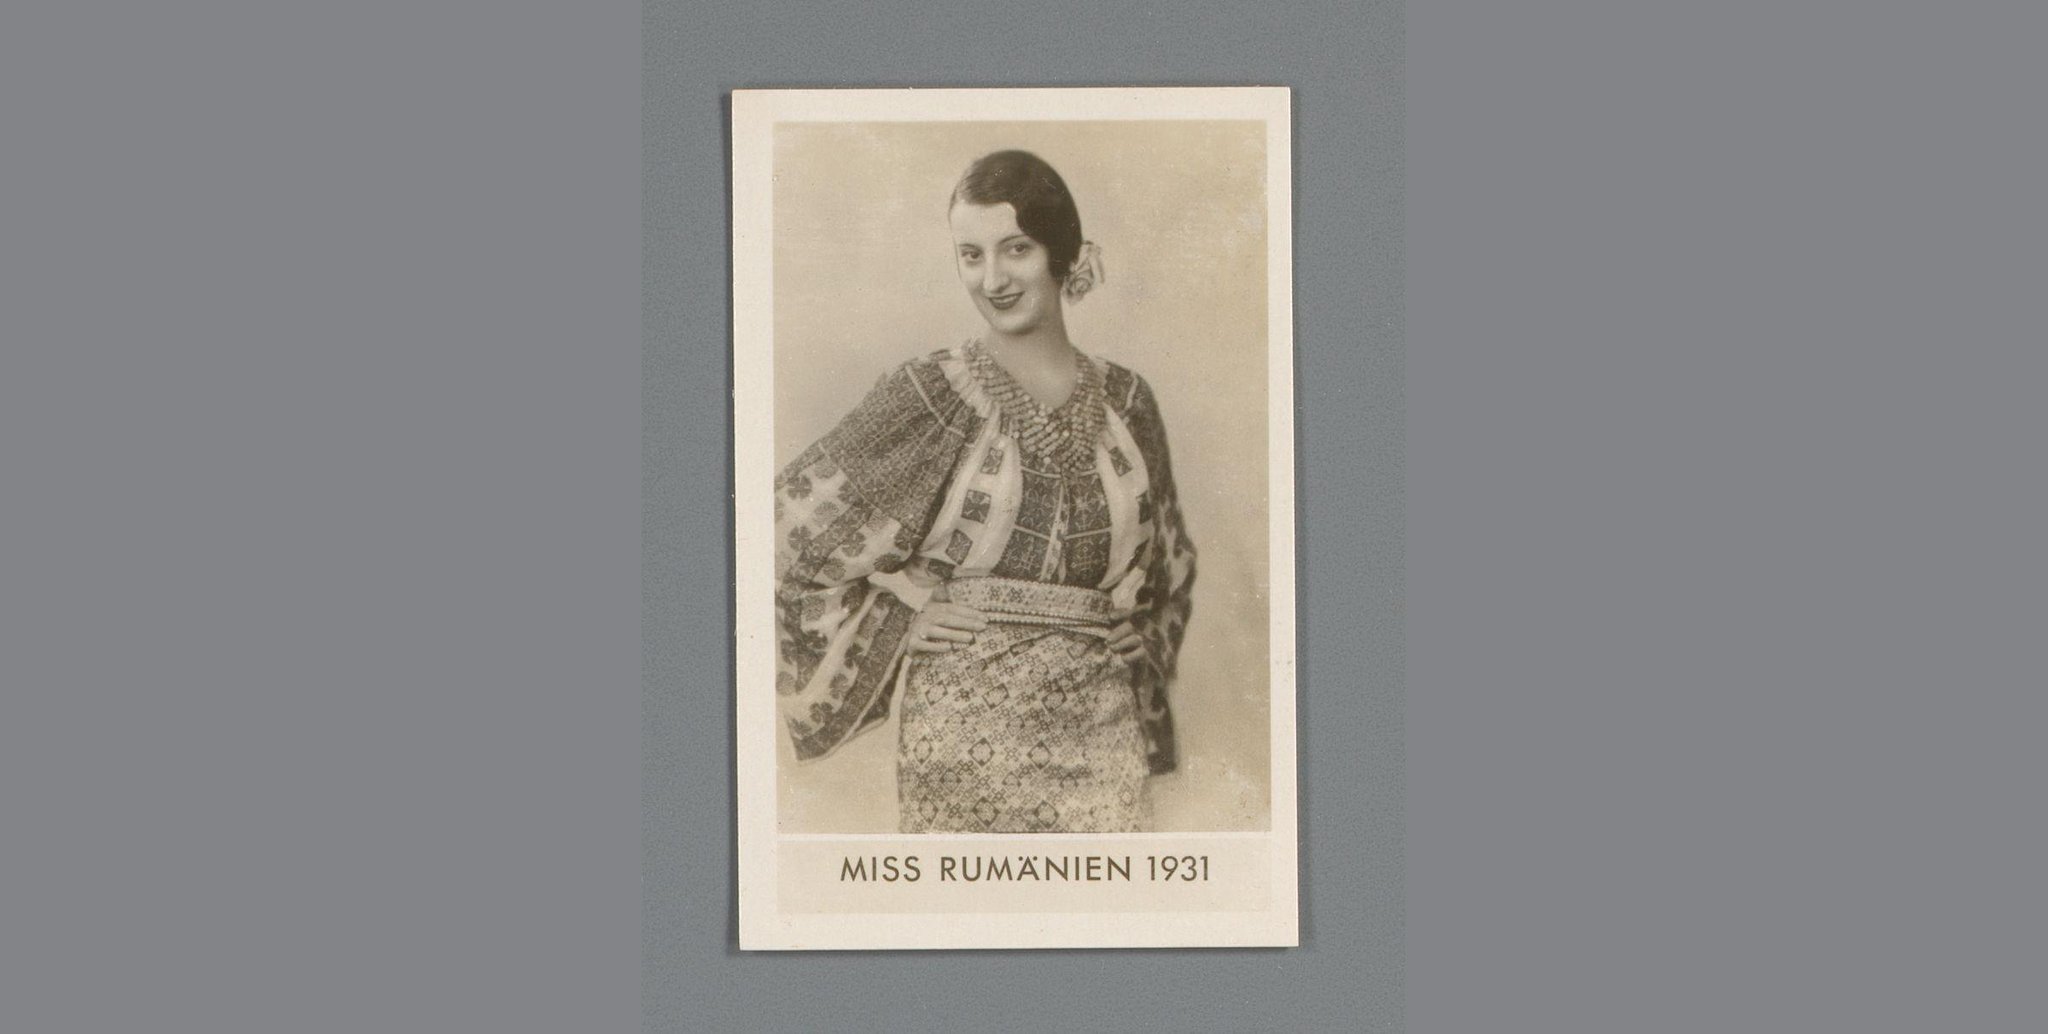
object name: photograph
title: Portret van Tanti Vuroseanu, Miss Roemenië 1931, reclame voor Club & Liga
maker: Anonymous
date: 1931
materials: paper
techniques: gelatin silver print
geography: dresden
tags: historical persons - bb - woman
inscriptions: inscription: ‘Die schönsten/ Frauen der Welt/ dargestellt durch die Schön-/ heitsköniginnen aller Länder,/ finden Sie in 190 echten/ Bromsilber-Fotos, die nur den/ CLUB-und-LIGA-Packun-/ gen beiliegen. Eind prächtiges/ Sammel-Album erhalten Sie/ für 75 Pfennig vom Händler/ oder bei Einsendung von/ 75 Pfennig in Briefmarken/ von der Bilderstelle Lohse,/ Dresden A24, Nossener Str. 1./ Ges. gesch. Nachdruck verboten!’